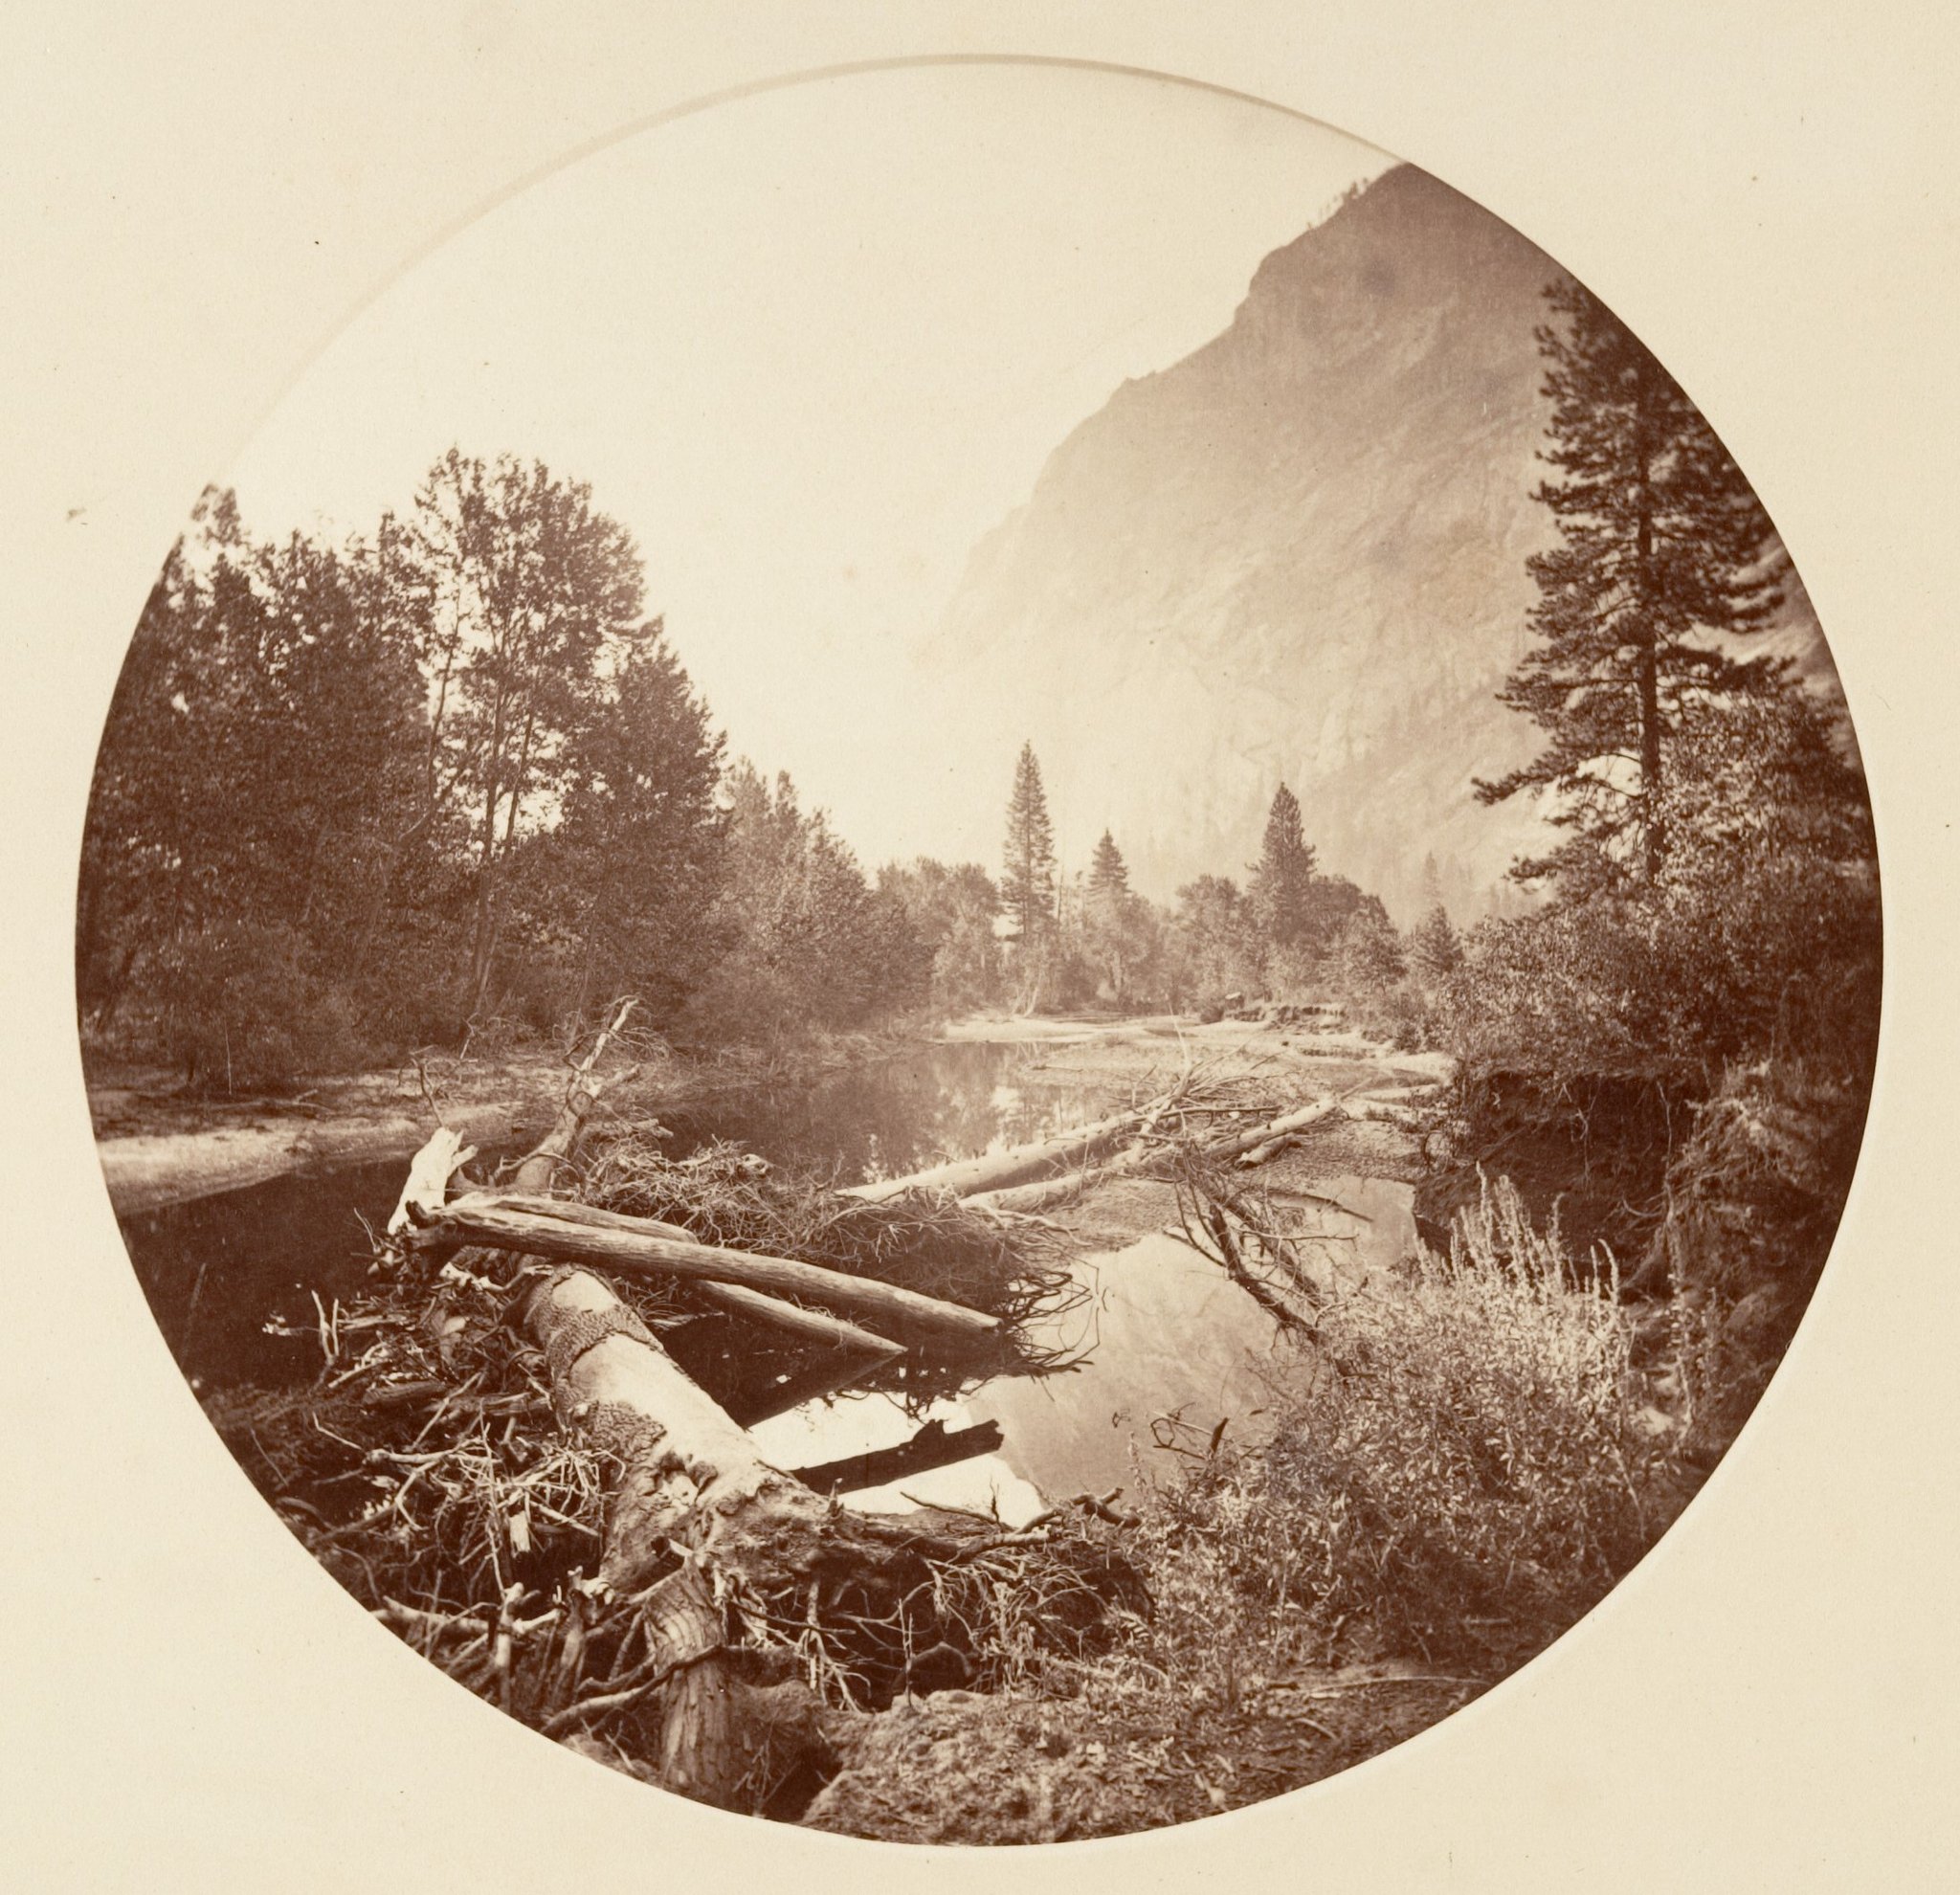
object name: photograph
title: [Yosemite National Park, California]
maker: carleton e. watkins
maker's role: artist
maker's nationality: american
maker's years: 1829-1916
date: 1878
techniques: albumen silver print, glass negative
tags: landscapes